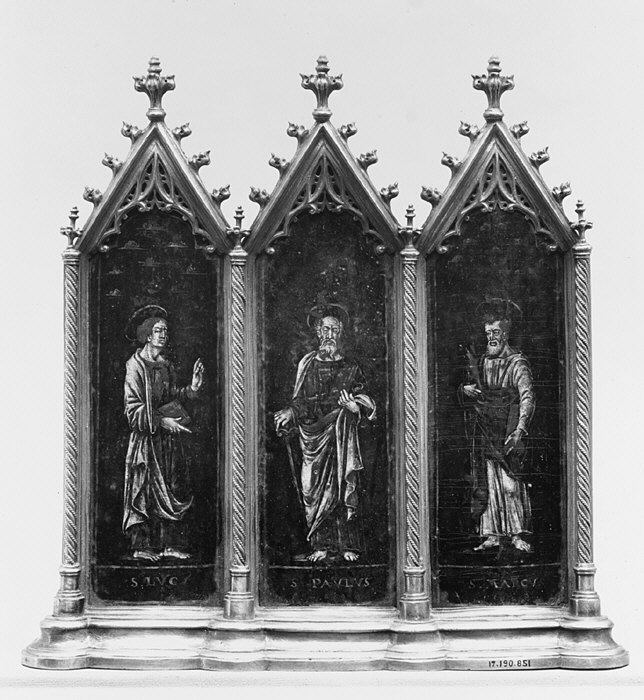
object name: triptych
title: Triptych (one of a pair)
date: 1801-1900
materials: copper, enamel, gilt, silver gilt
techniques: painting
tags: men